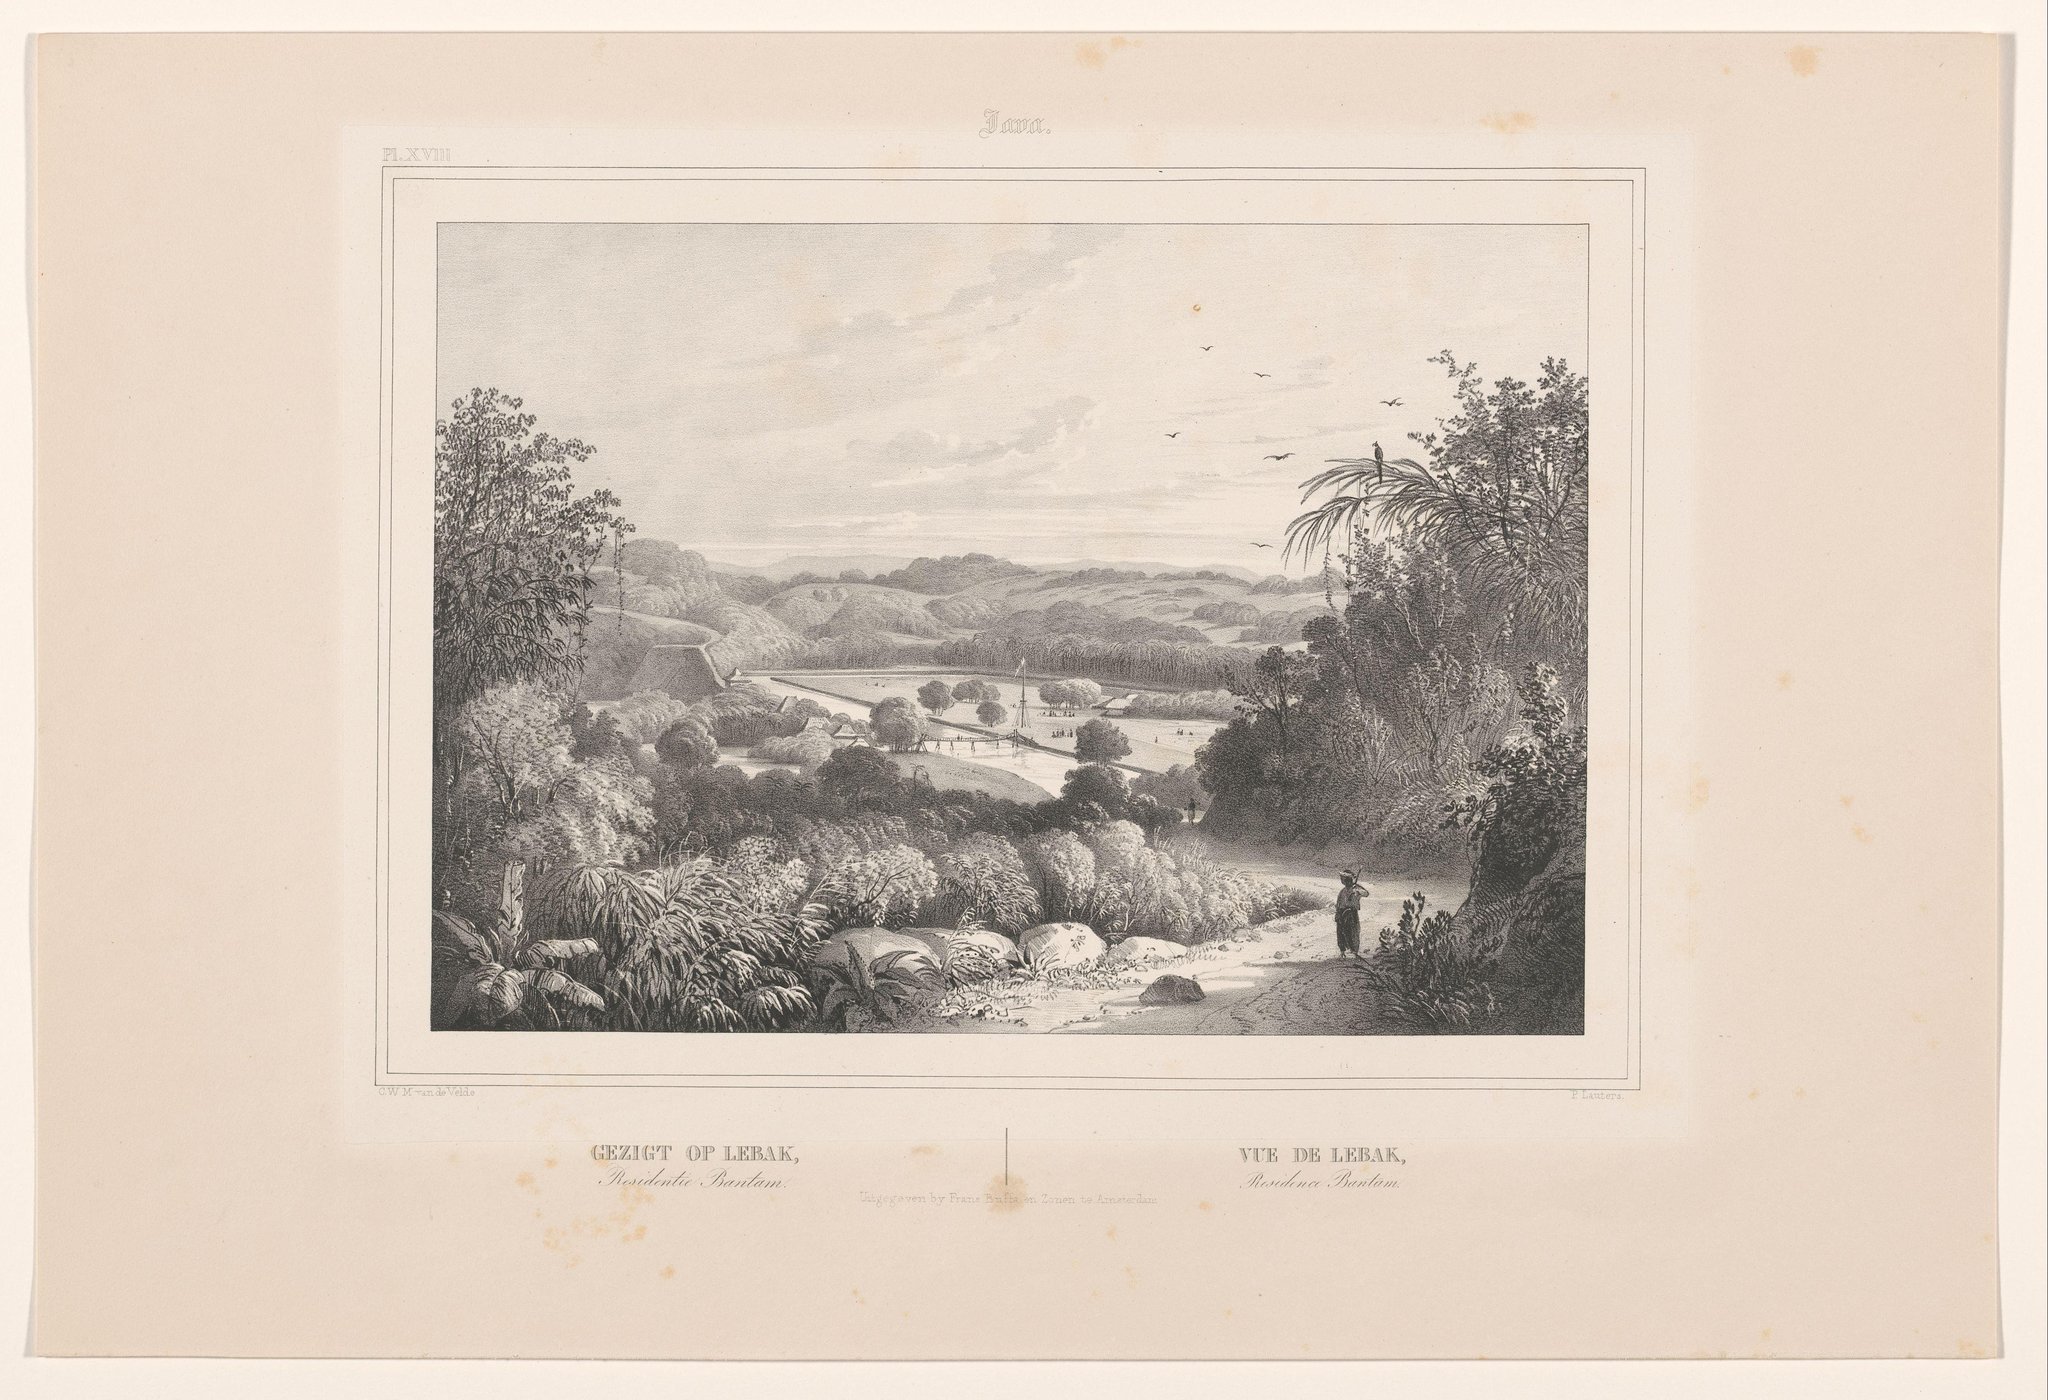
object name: print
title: Java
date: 1843-1845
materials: paper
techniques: lithograph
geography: brussels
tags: dale, valley, landscapes in the non-temperate zone, exotic landscapes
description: Rechts op de weg staat een man. Genummerd linksboven: Pl. XVIII. De prent maakt deel uit van een omslag met zes bladen.